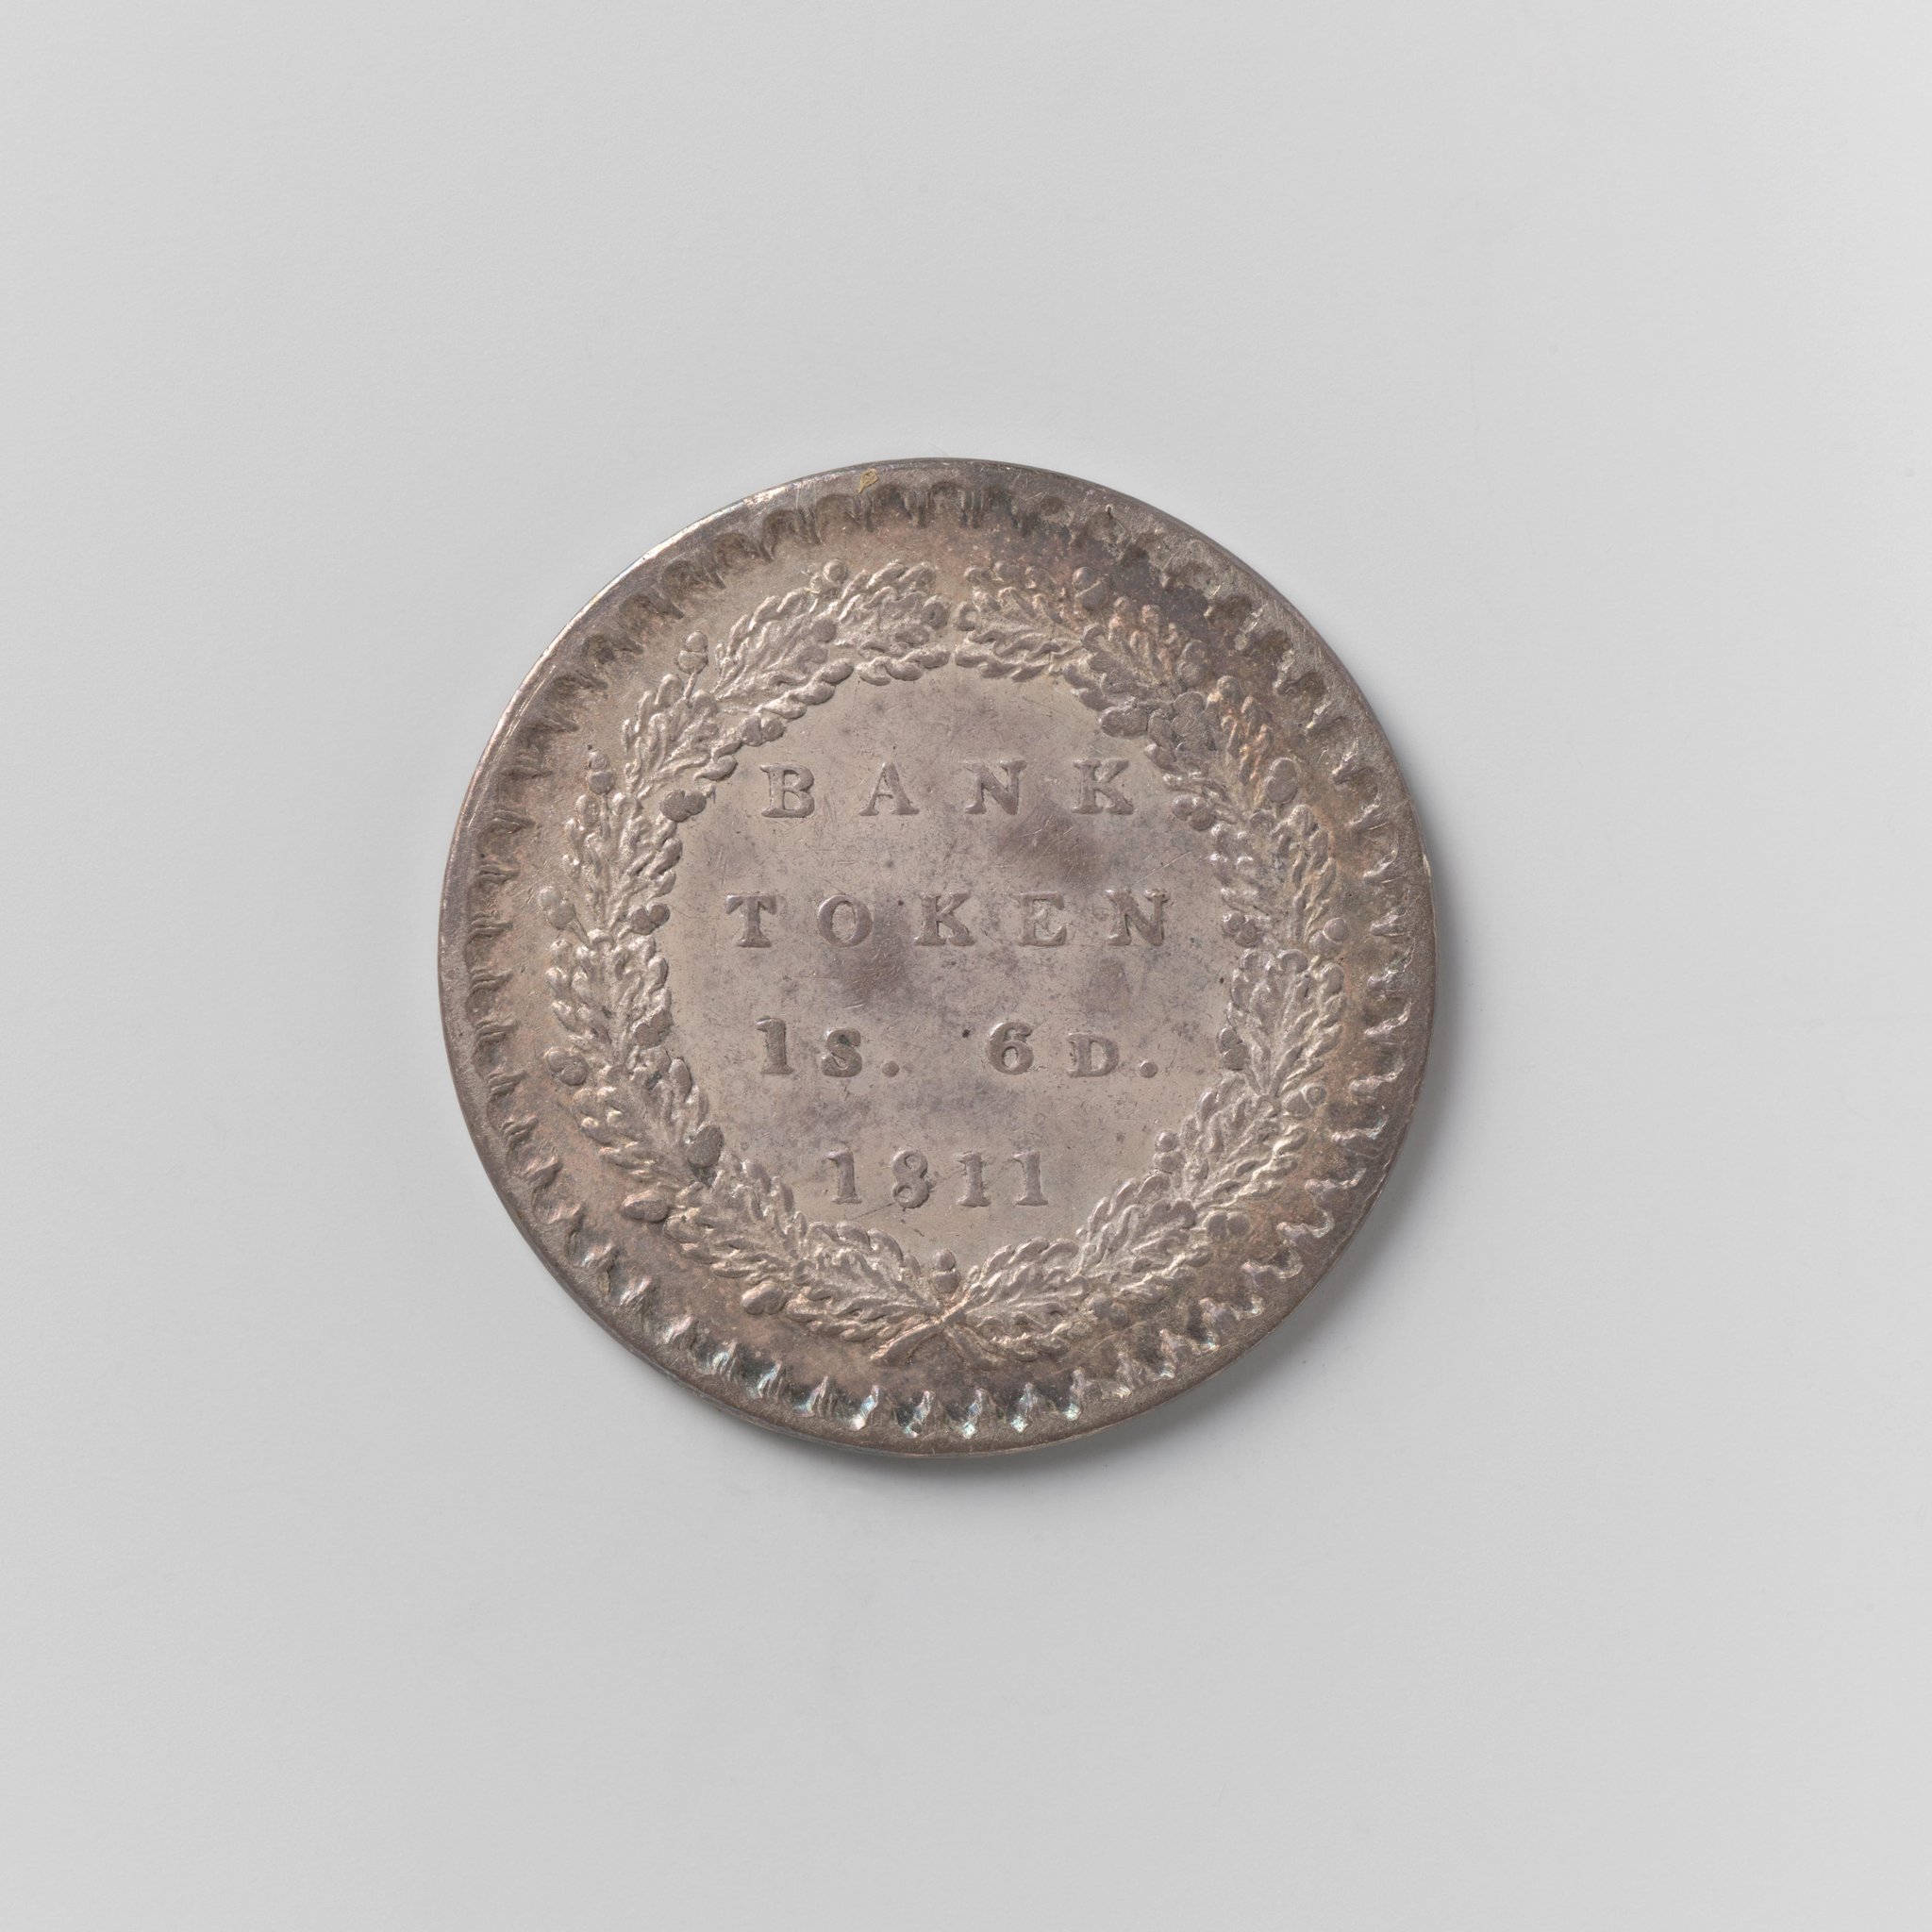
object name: coin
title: Engeland, George III, banktoken van 18 pence, 1811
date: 1811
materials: silver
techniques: striking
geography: birmingham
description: Zilveren munt. Voorzijde: gelauwerd borstbeeld van de koning naar rechts. Keerzijde: binnen twee samengebonden eikentakken drie-regelig opschrift met waarde-aanduiding, waaronder jaartal. Gladde rand.